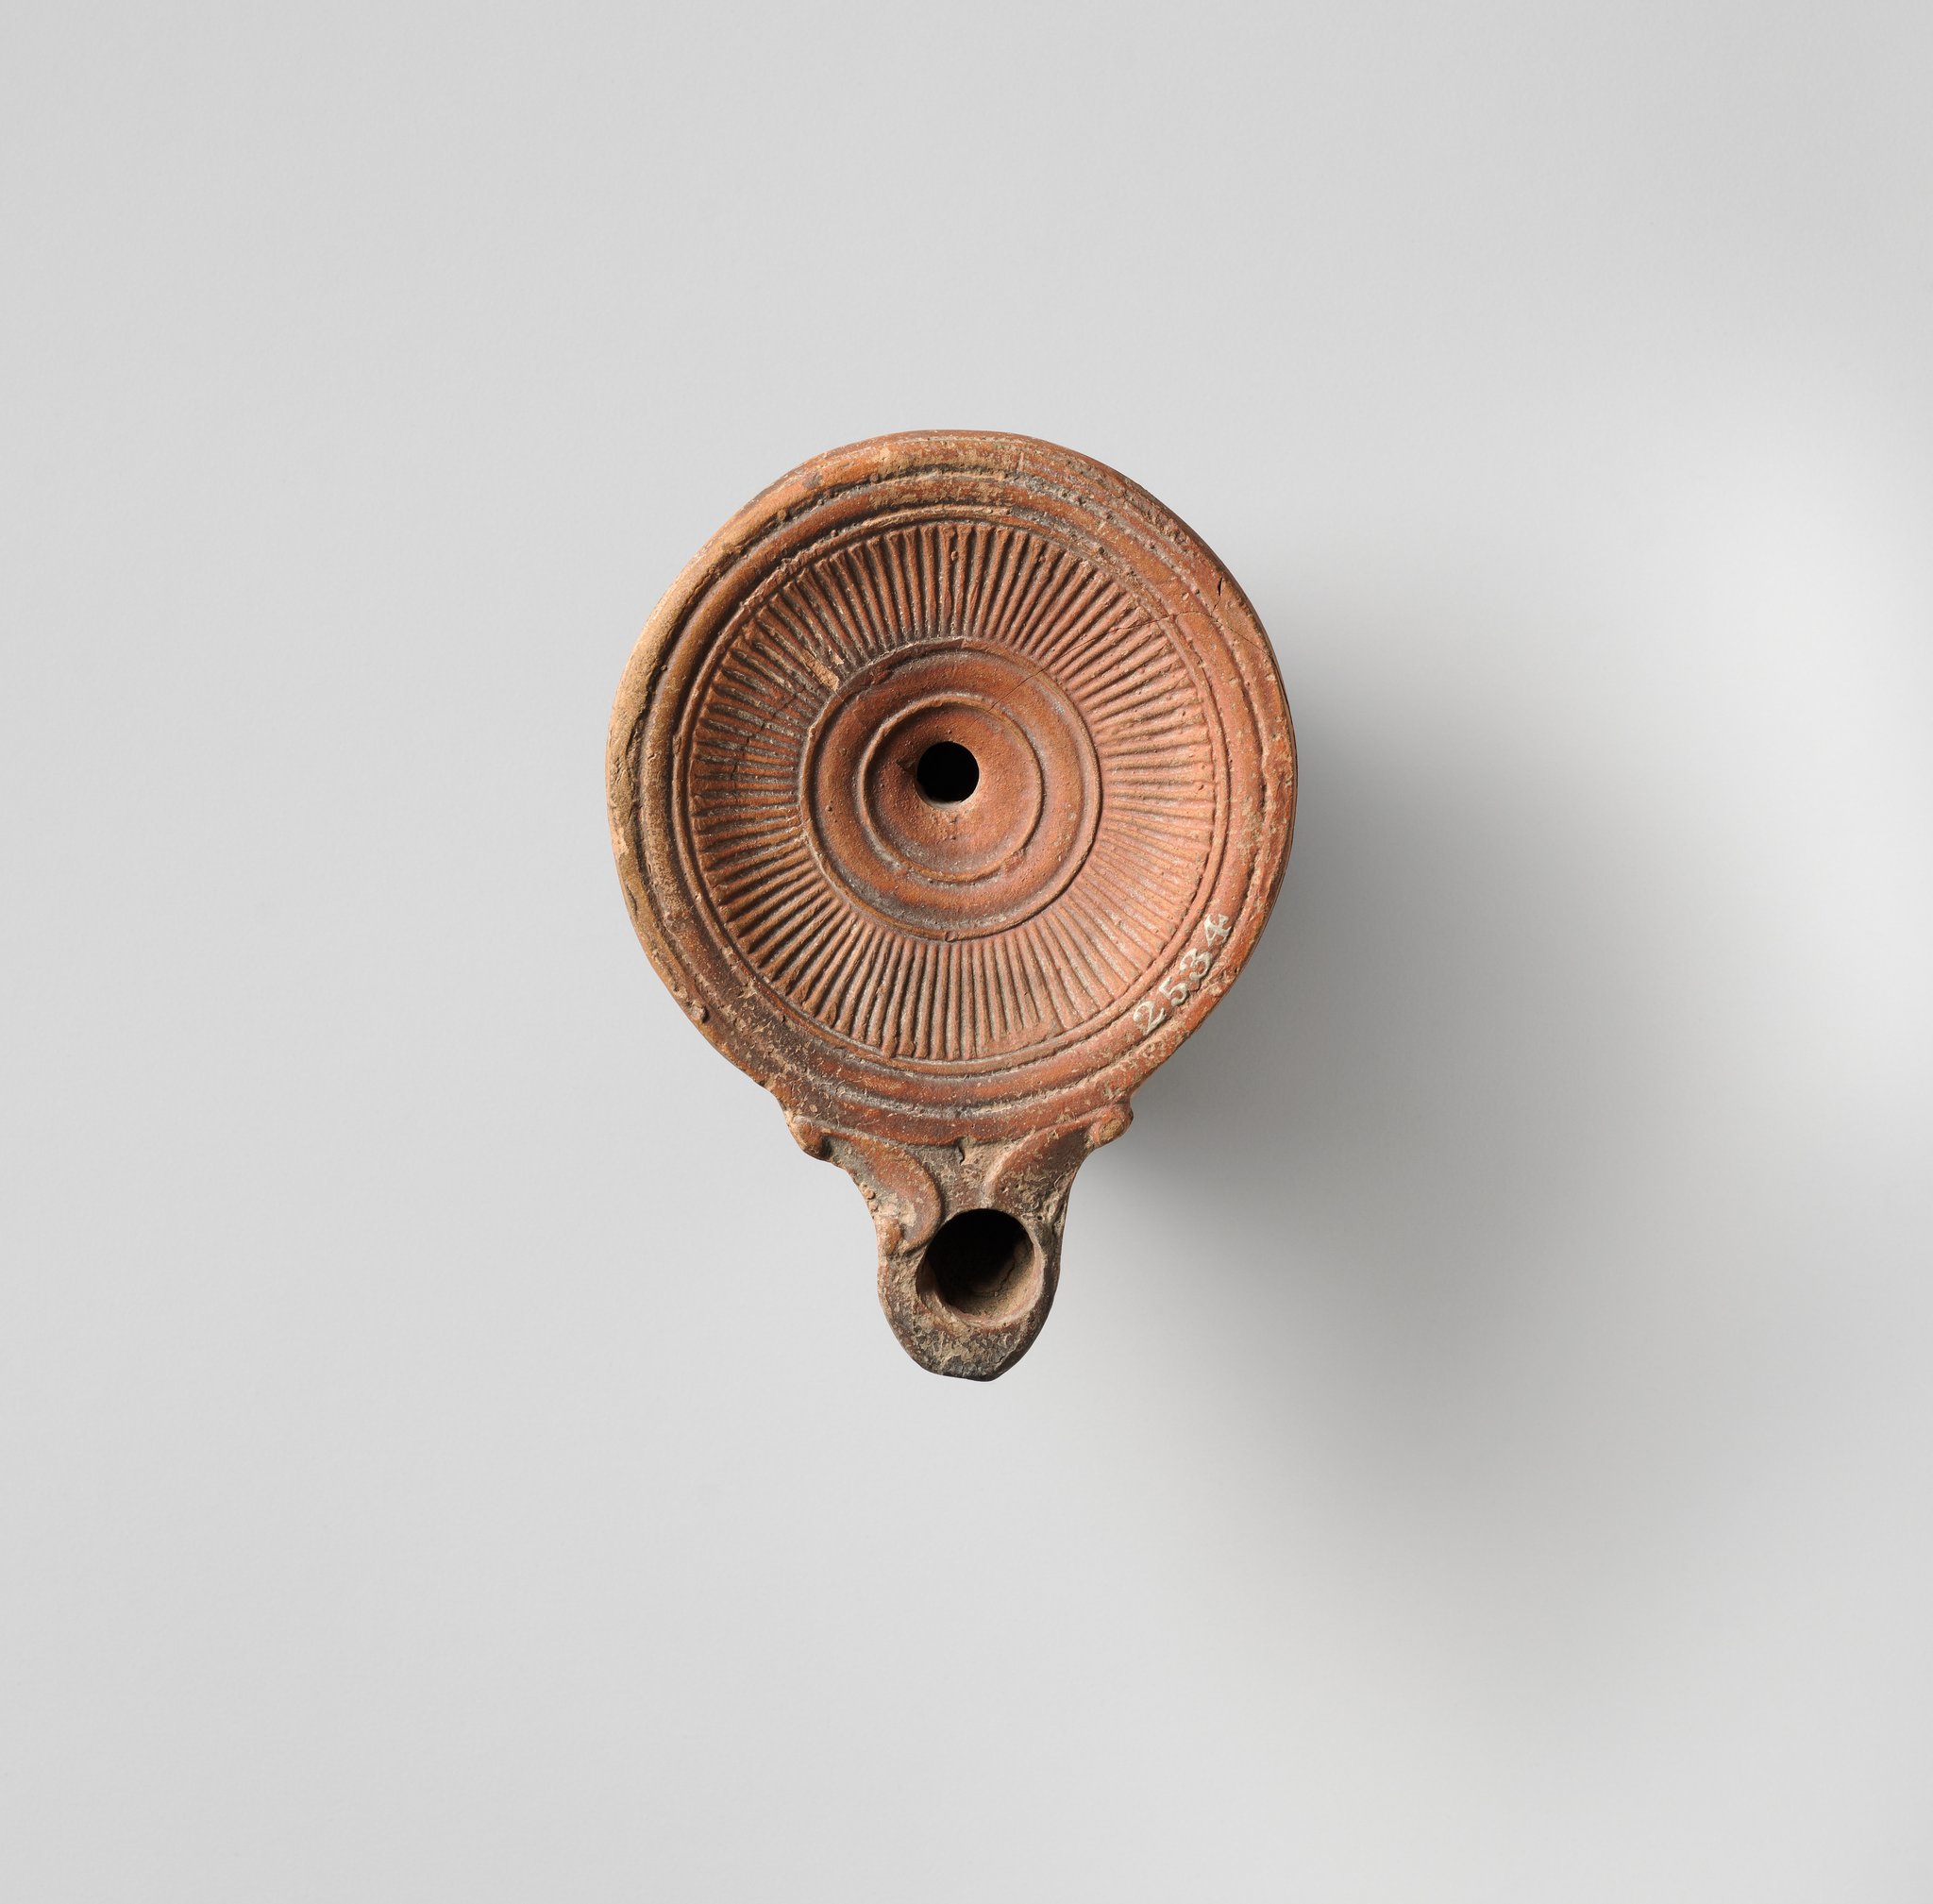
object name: lamp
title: Terracotta oil lamp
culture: roman, cypriot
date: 40-100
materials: terracotta